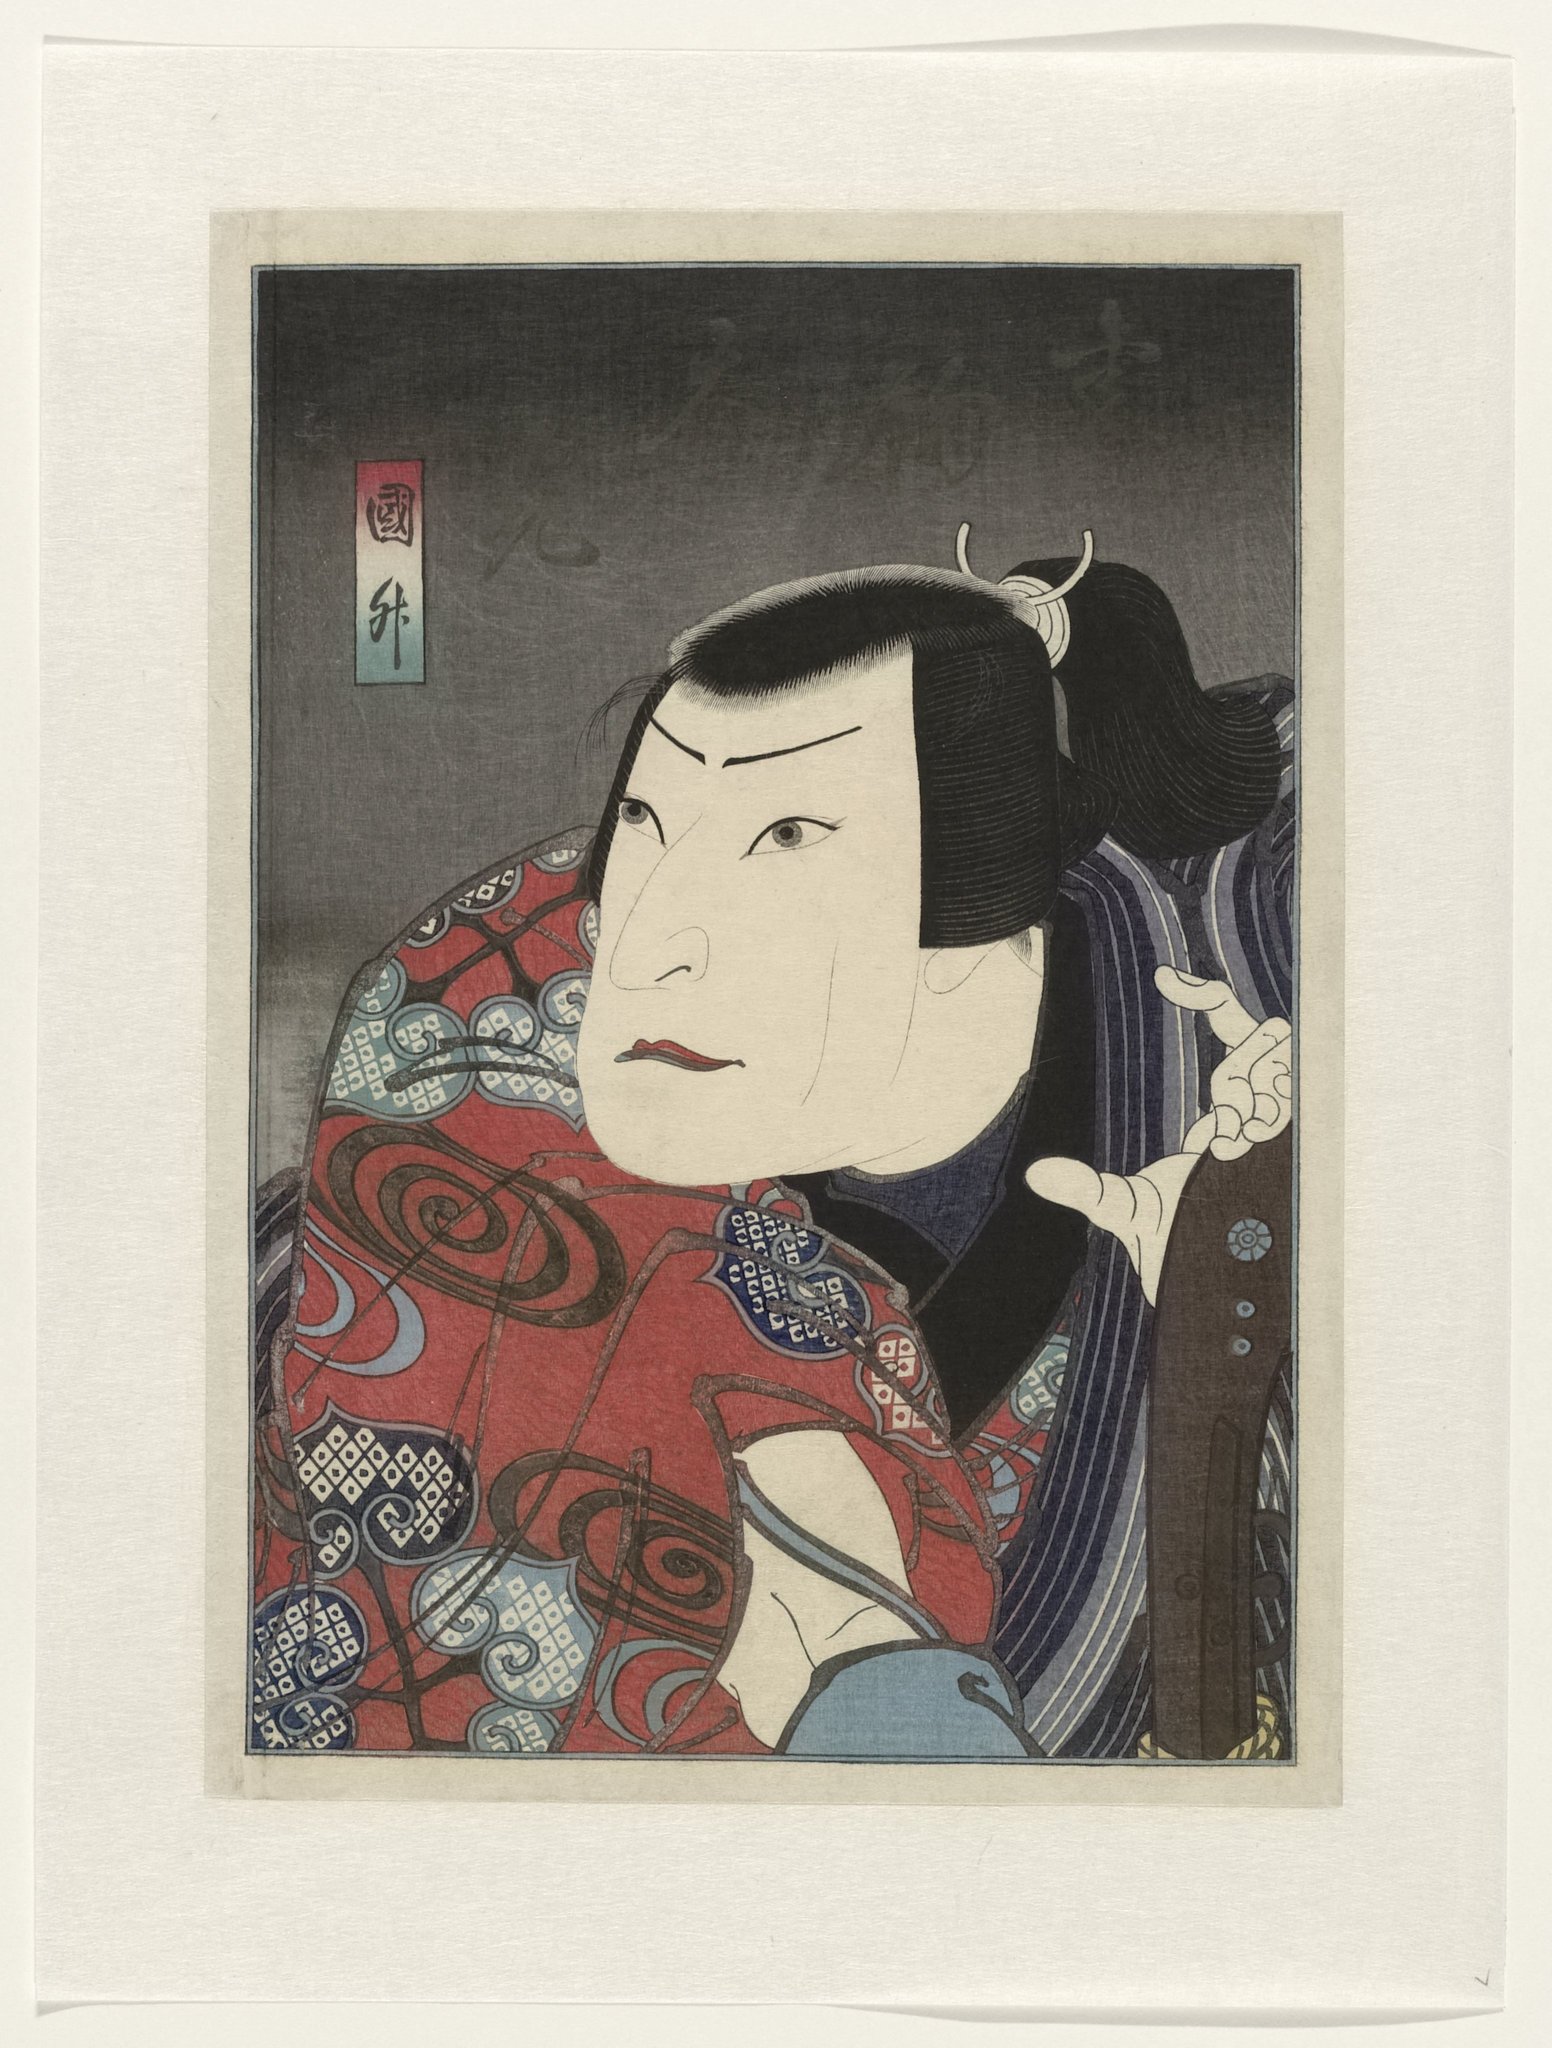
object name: print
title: Jitsukawa Enzaburô I als Kanemari Daisuke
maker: utagawa kunimasu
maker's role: print maker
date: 1848-1849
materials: paper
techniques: woodcut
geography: osaka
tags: portrait of actor, actress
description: Jitsukawa Enzaburô I als Kanemari Daisuke.